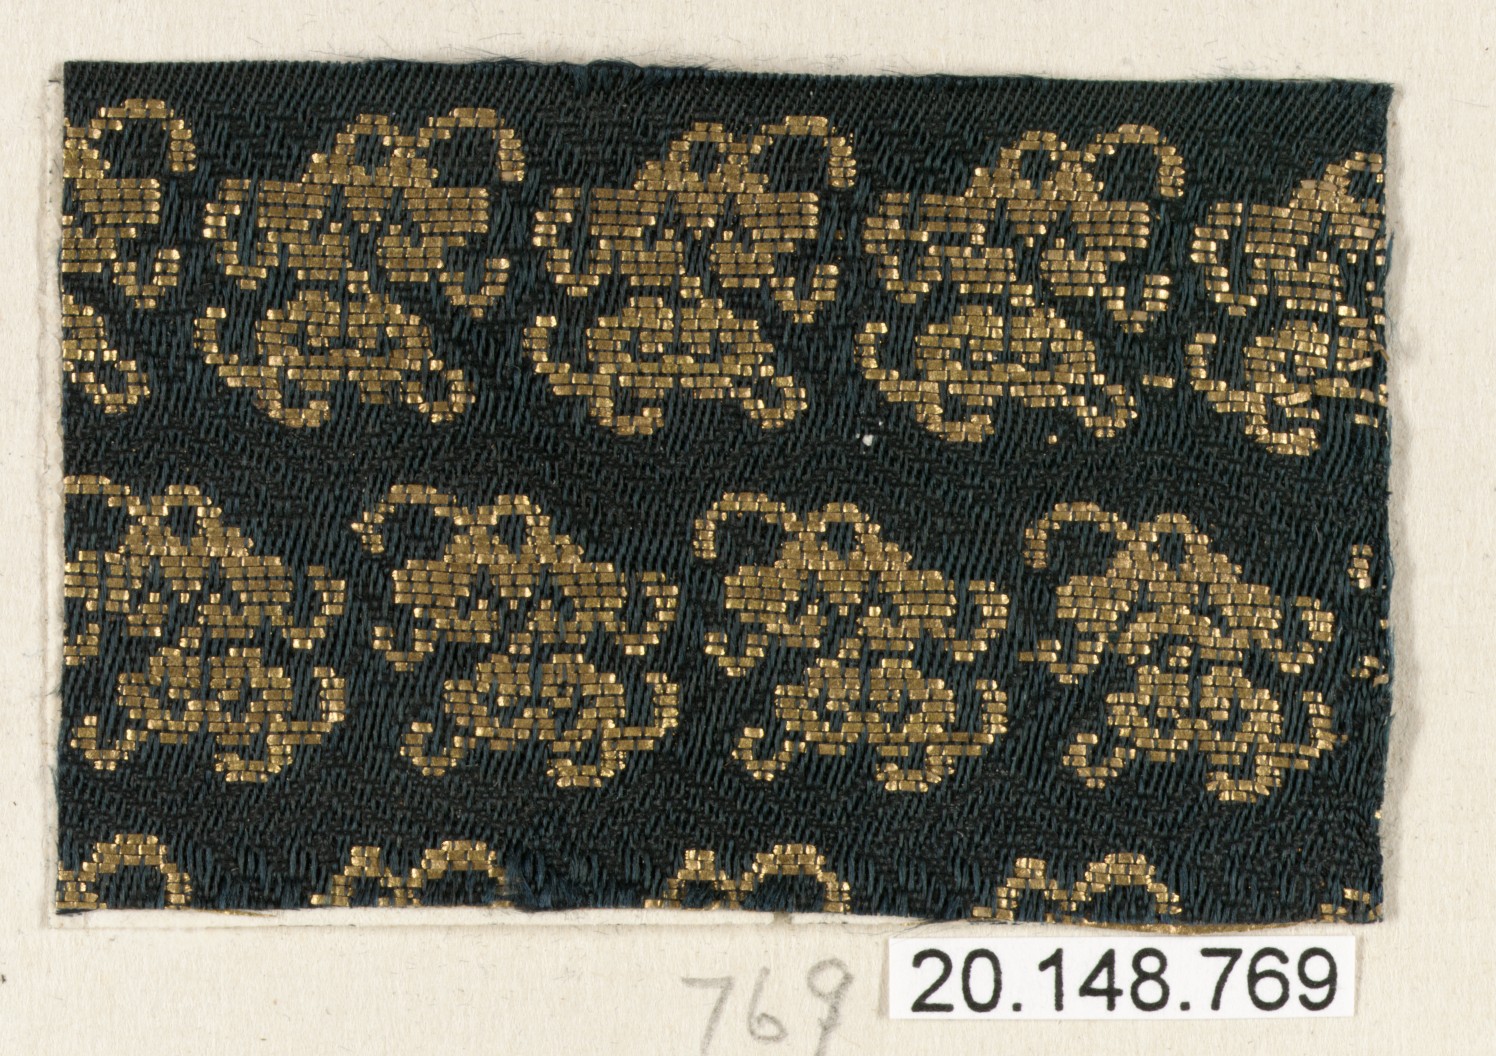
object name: piece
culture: japanese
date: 1601-1700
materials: silk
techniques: compound weave